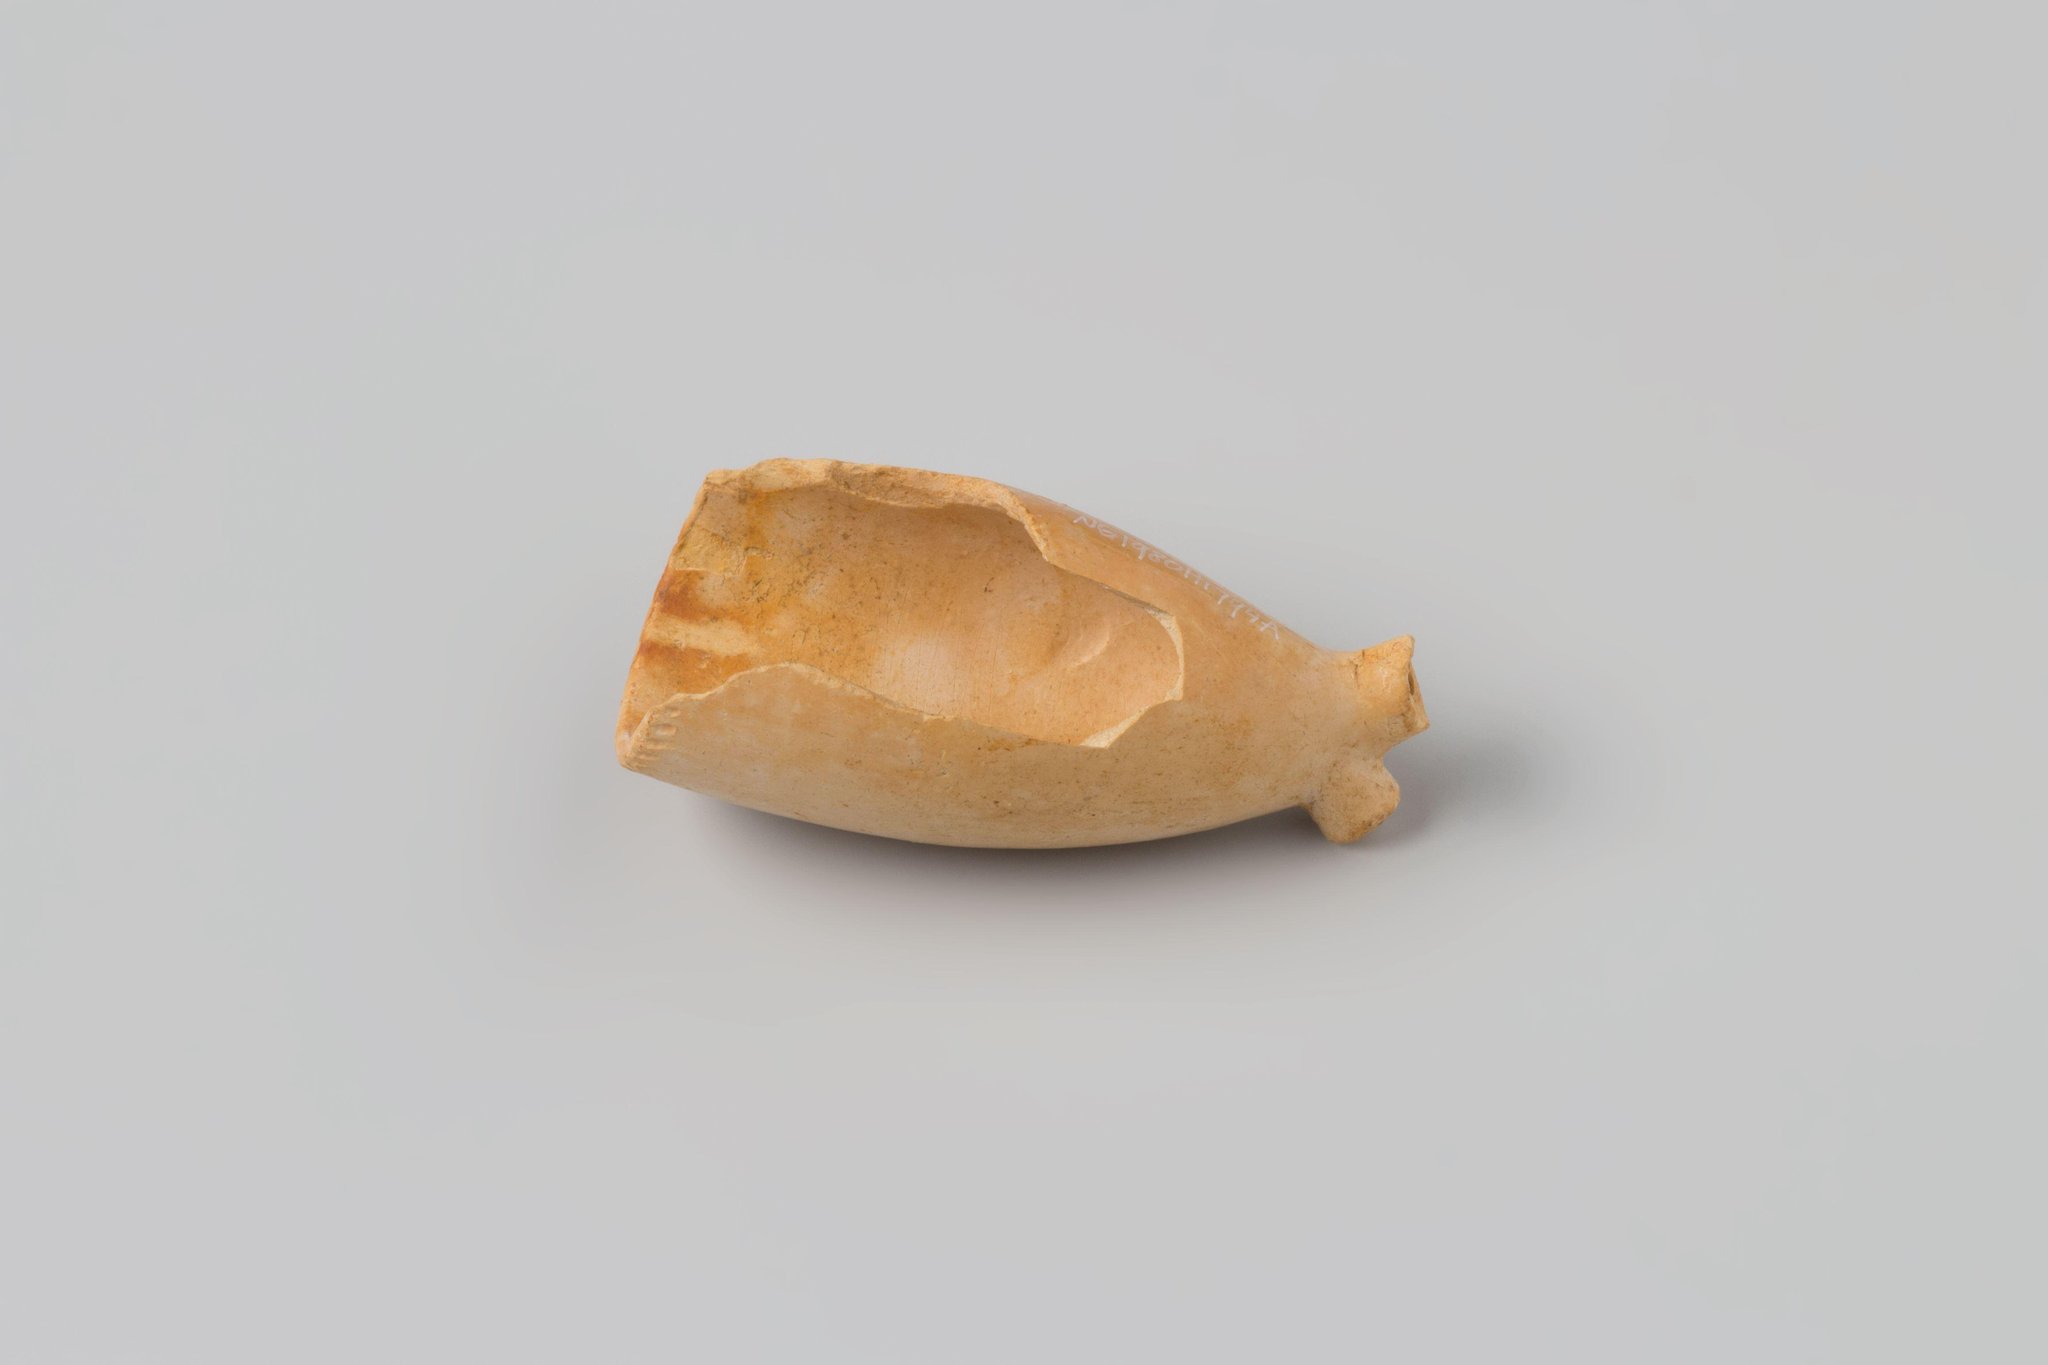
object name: pipe bowl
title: Fragment pijpenkop uit het wrak van de Oost-Indiëvaarder Hollandia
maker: Anonymous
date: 1700-1743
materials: clay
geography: netherlands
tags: verenigde oostindische compagnie, hollandia (schip), annet